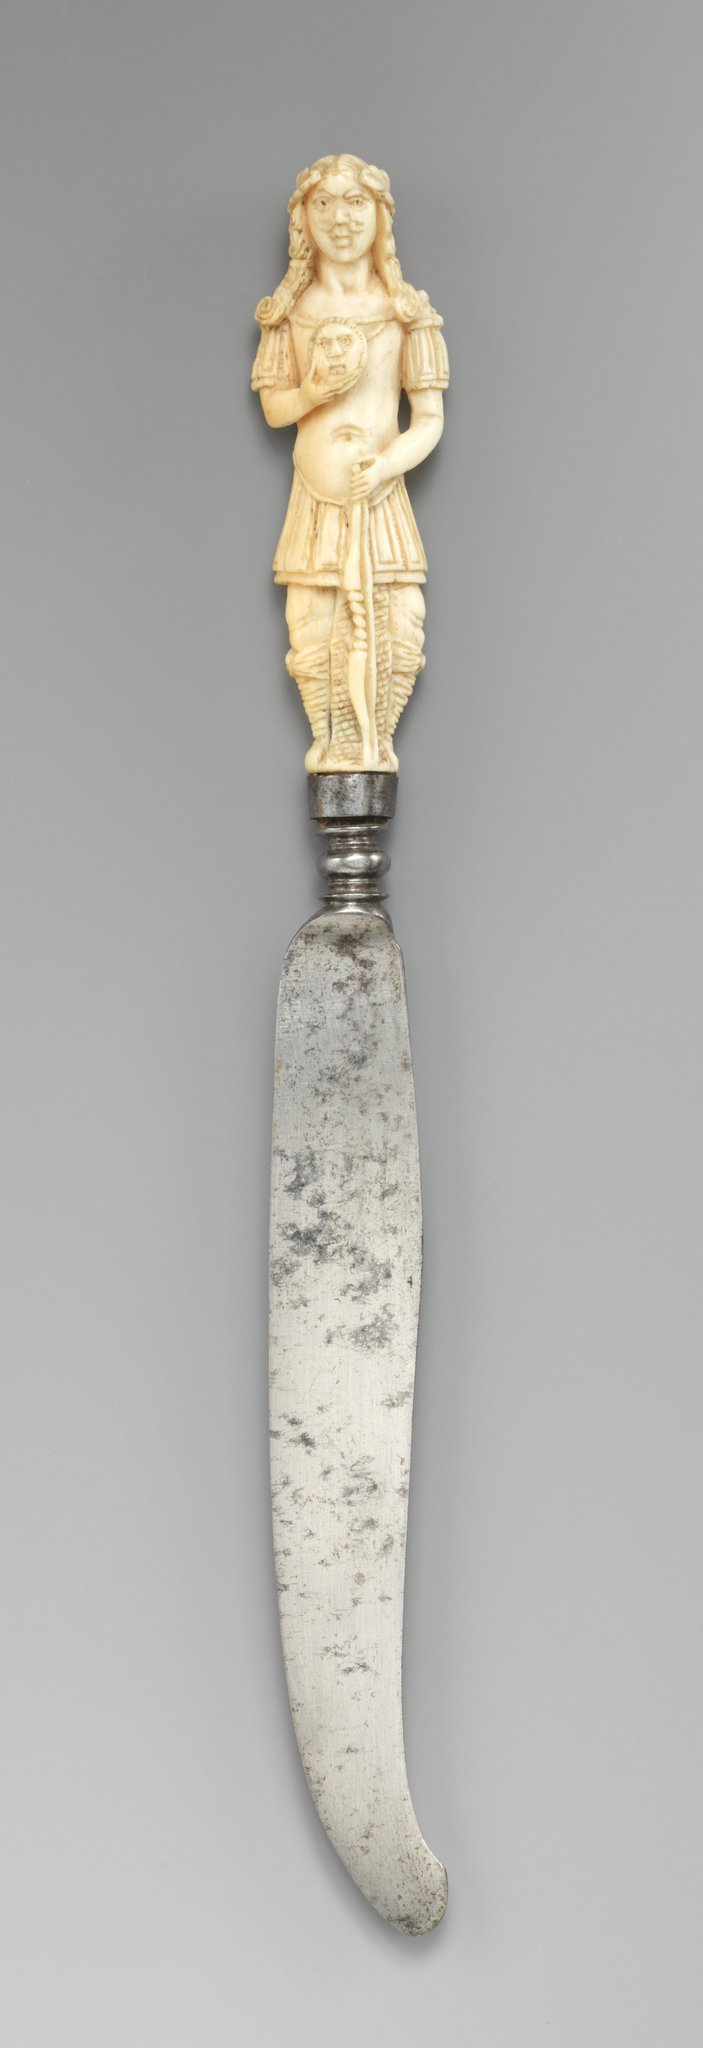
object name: knife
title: Knife with carved handle in the form of Apollo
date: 1767-1800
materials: ivory, steel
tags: apollo,diana